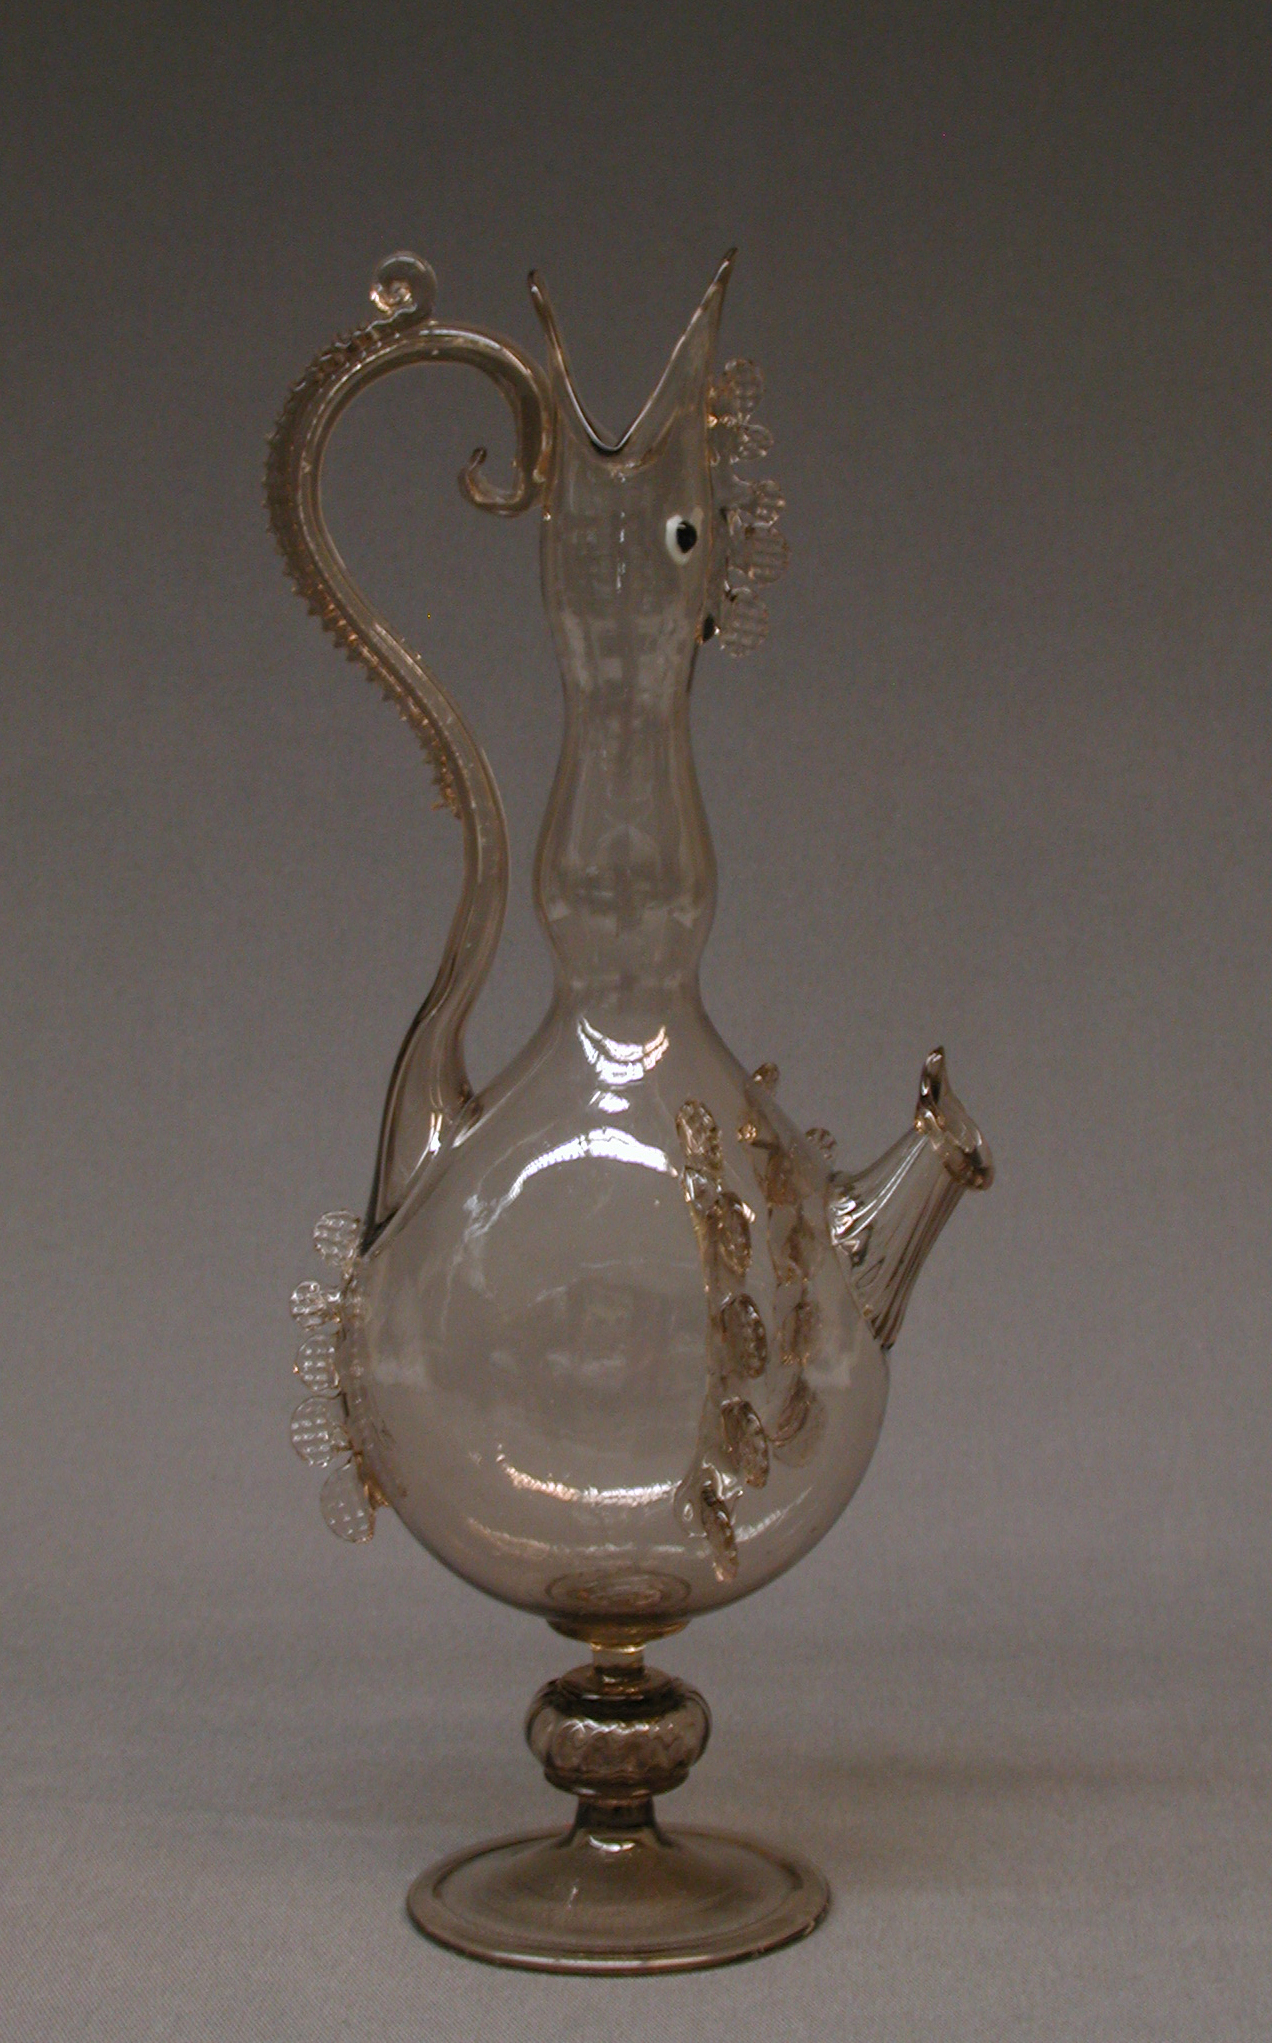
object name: ewer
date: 1867-1900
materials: glass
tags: animals